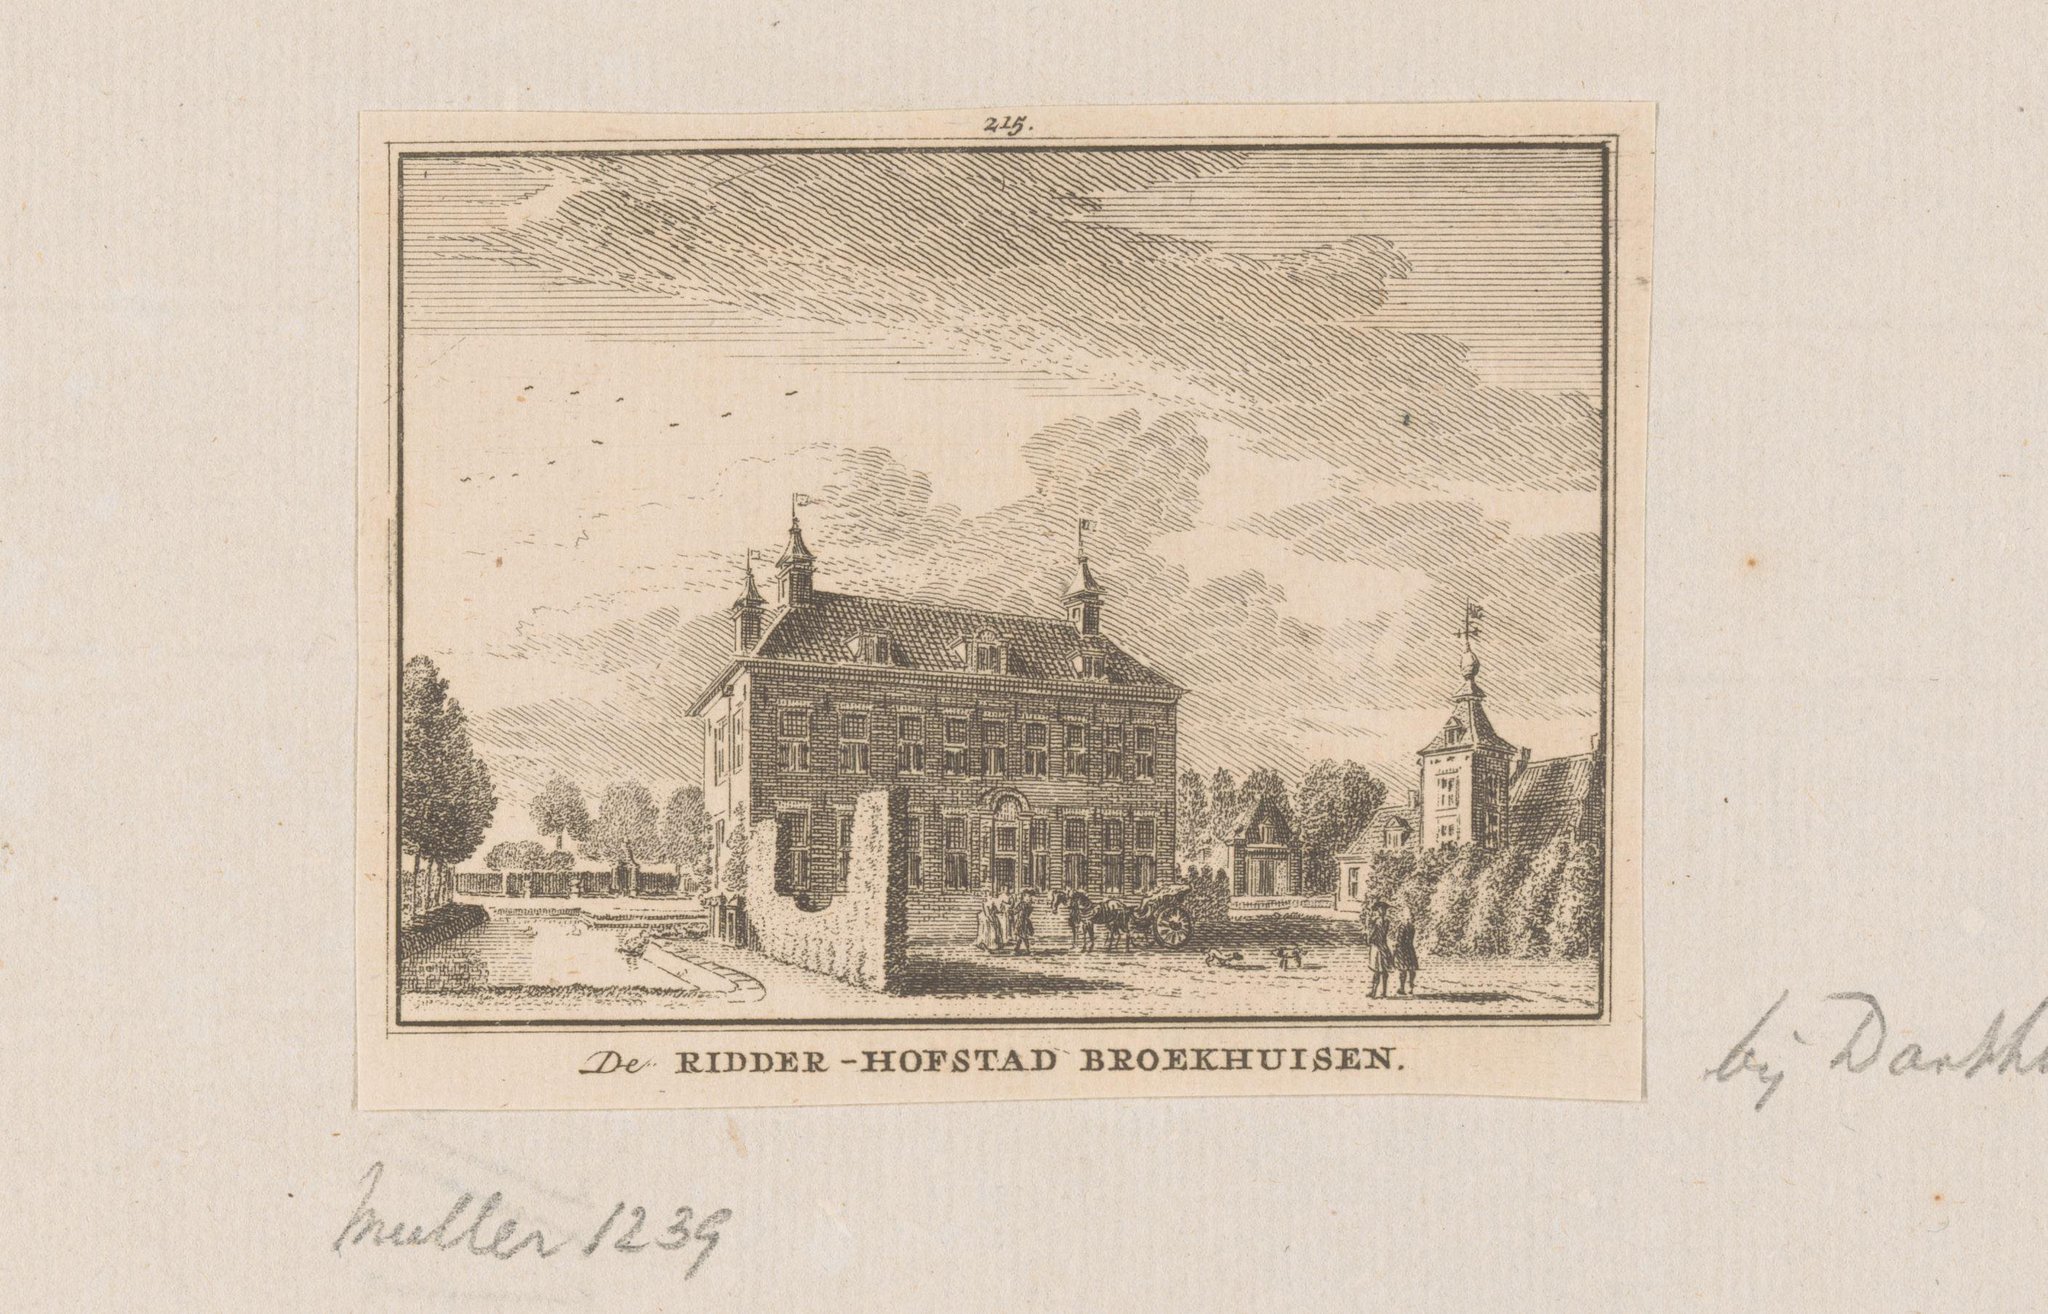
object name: book illustration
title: De Ridder-Hofstad Broekhuisen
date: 1773-1792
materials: paper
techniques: etching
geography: haarlem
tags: castle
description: Prent gebruikt in: Het verheerlykt Nederland of kabinet van hedendaagsche gezigten van steden, dorpen (…). 9 dln. Amsterdam: Isaak Tirion en weduwe Isaak Tirion, 1745-1774, ill. 215. Of in: Nederlandsche tafereelen; of eene keurige verzameling van negen honderd fraaije gezigten van steden, dorpen, sloten, oudheden (….). 9 dln. Amsterdam: Jan de Groot, 1792, ill. 215.